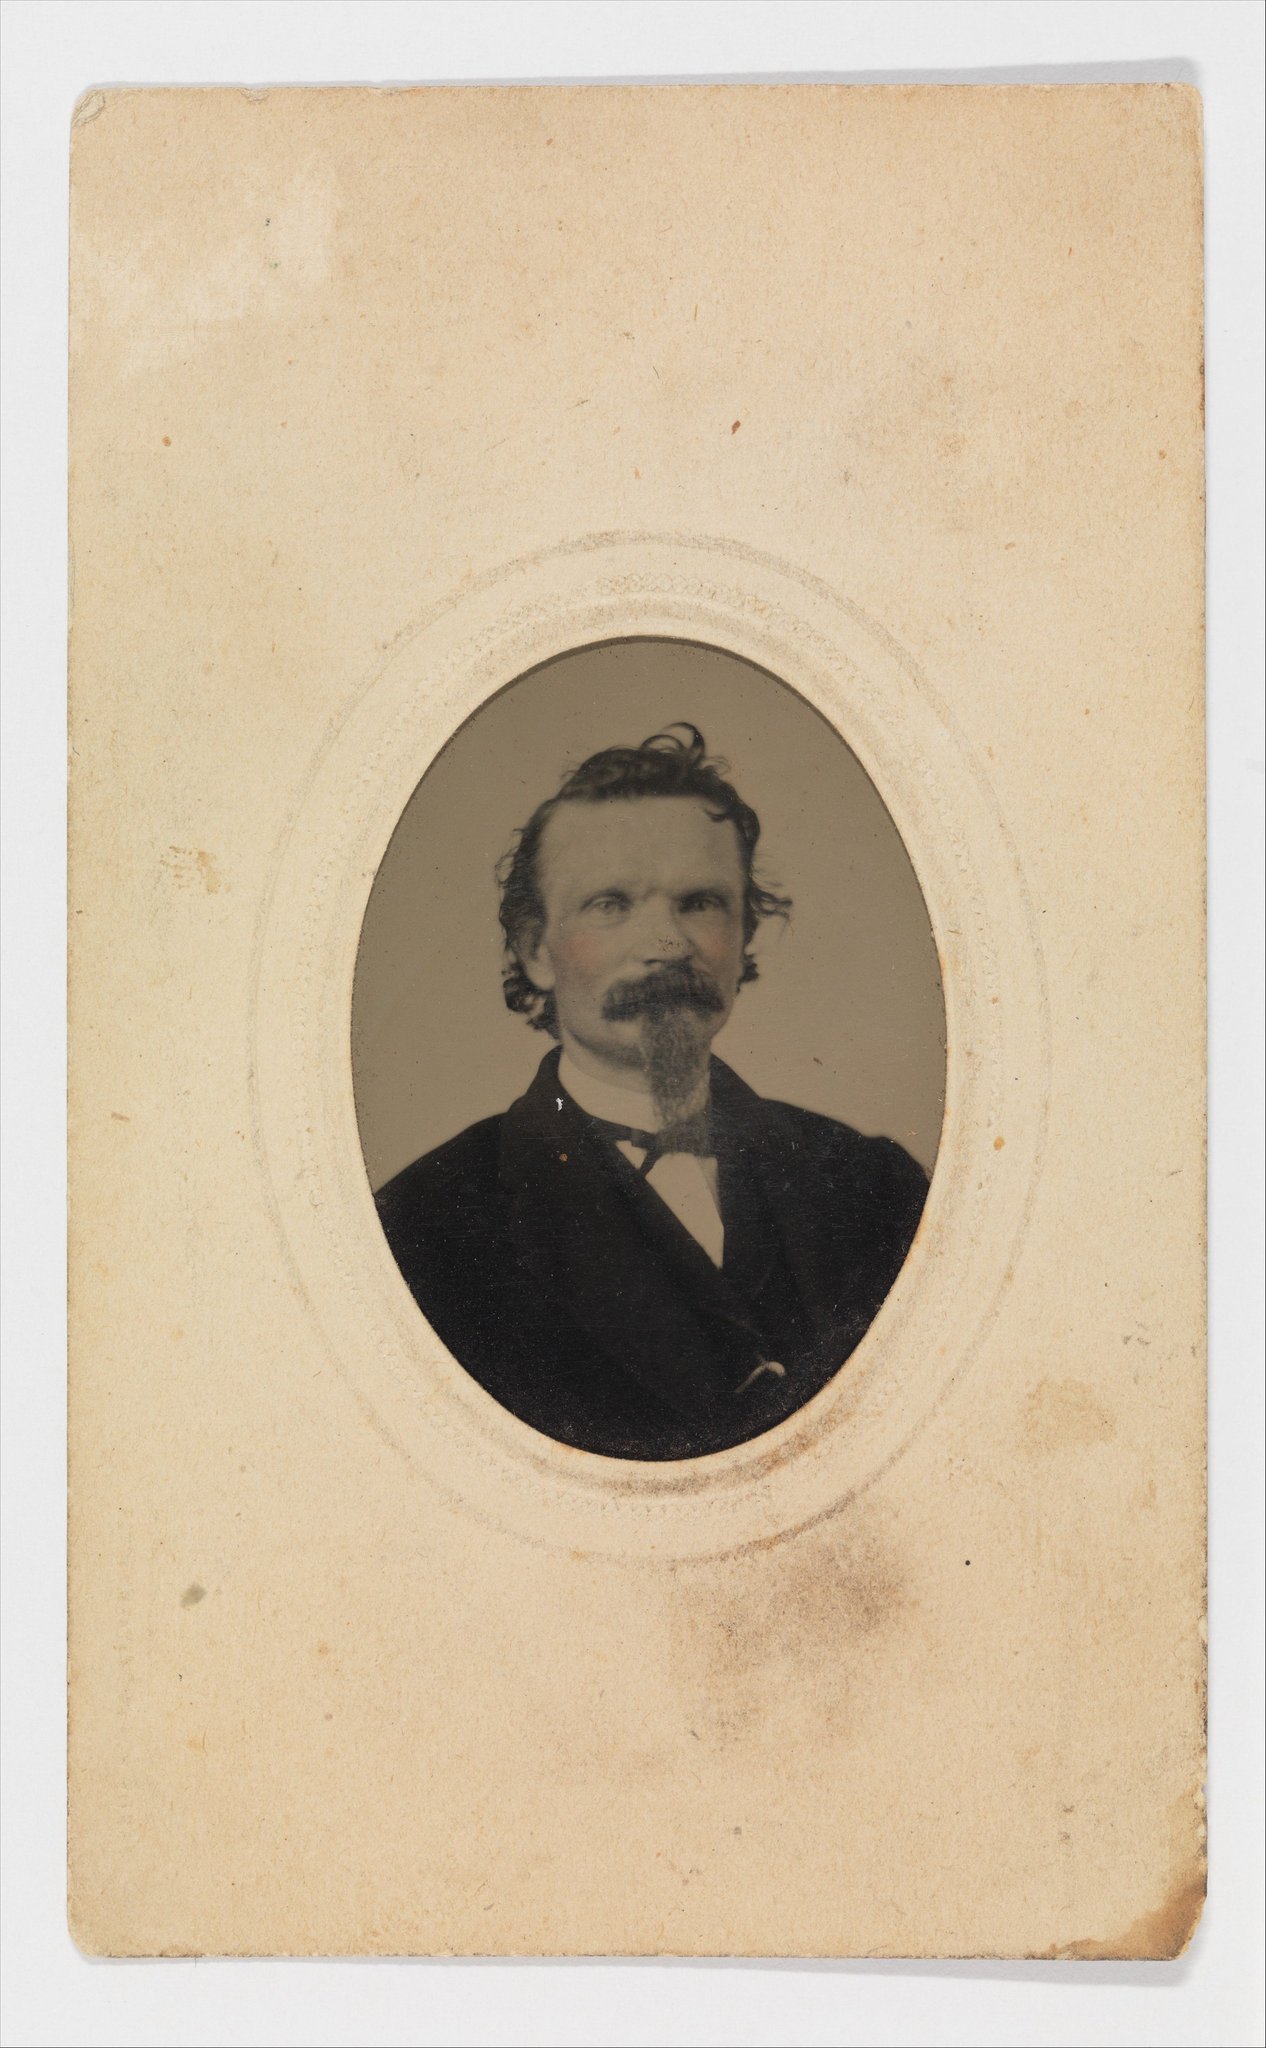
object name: tintype photograph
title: Tintype Photograph of Gustave Young (1827–1895)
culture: american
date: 1860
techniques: tintype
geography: united states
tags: men,portraits